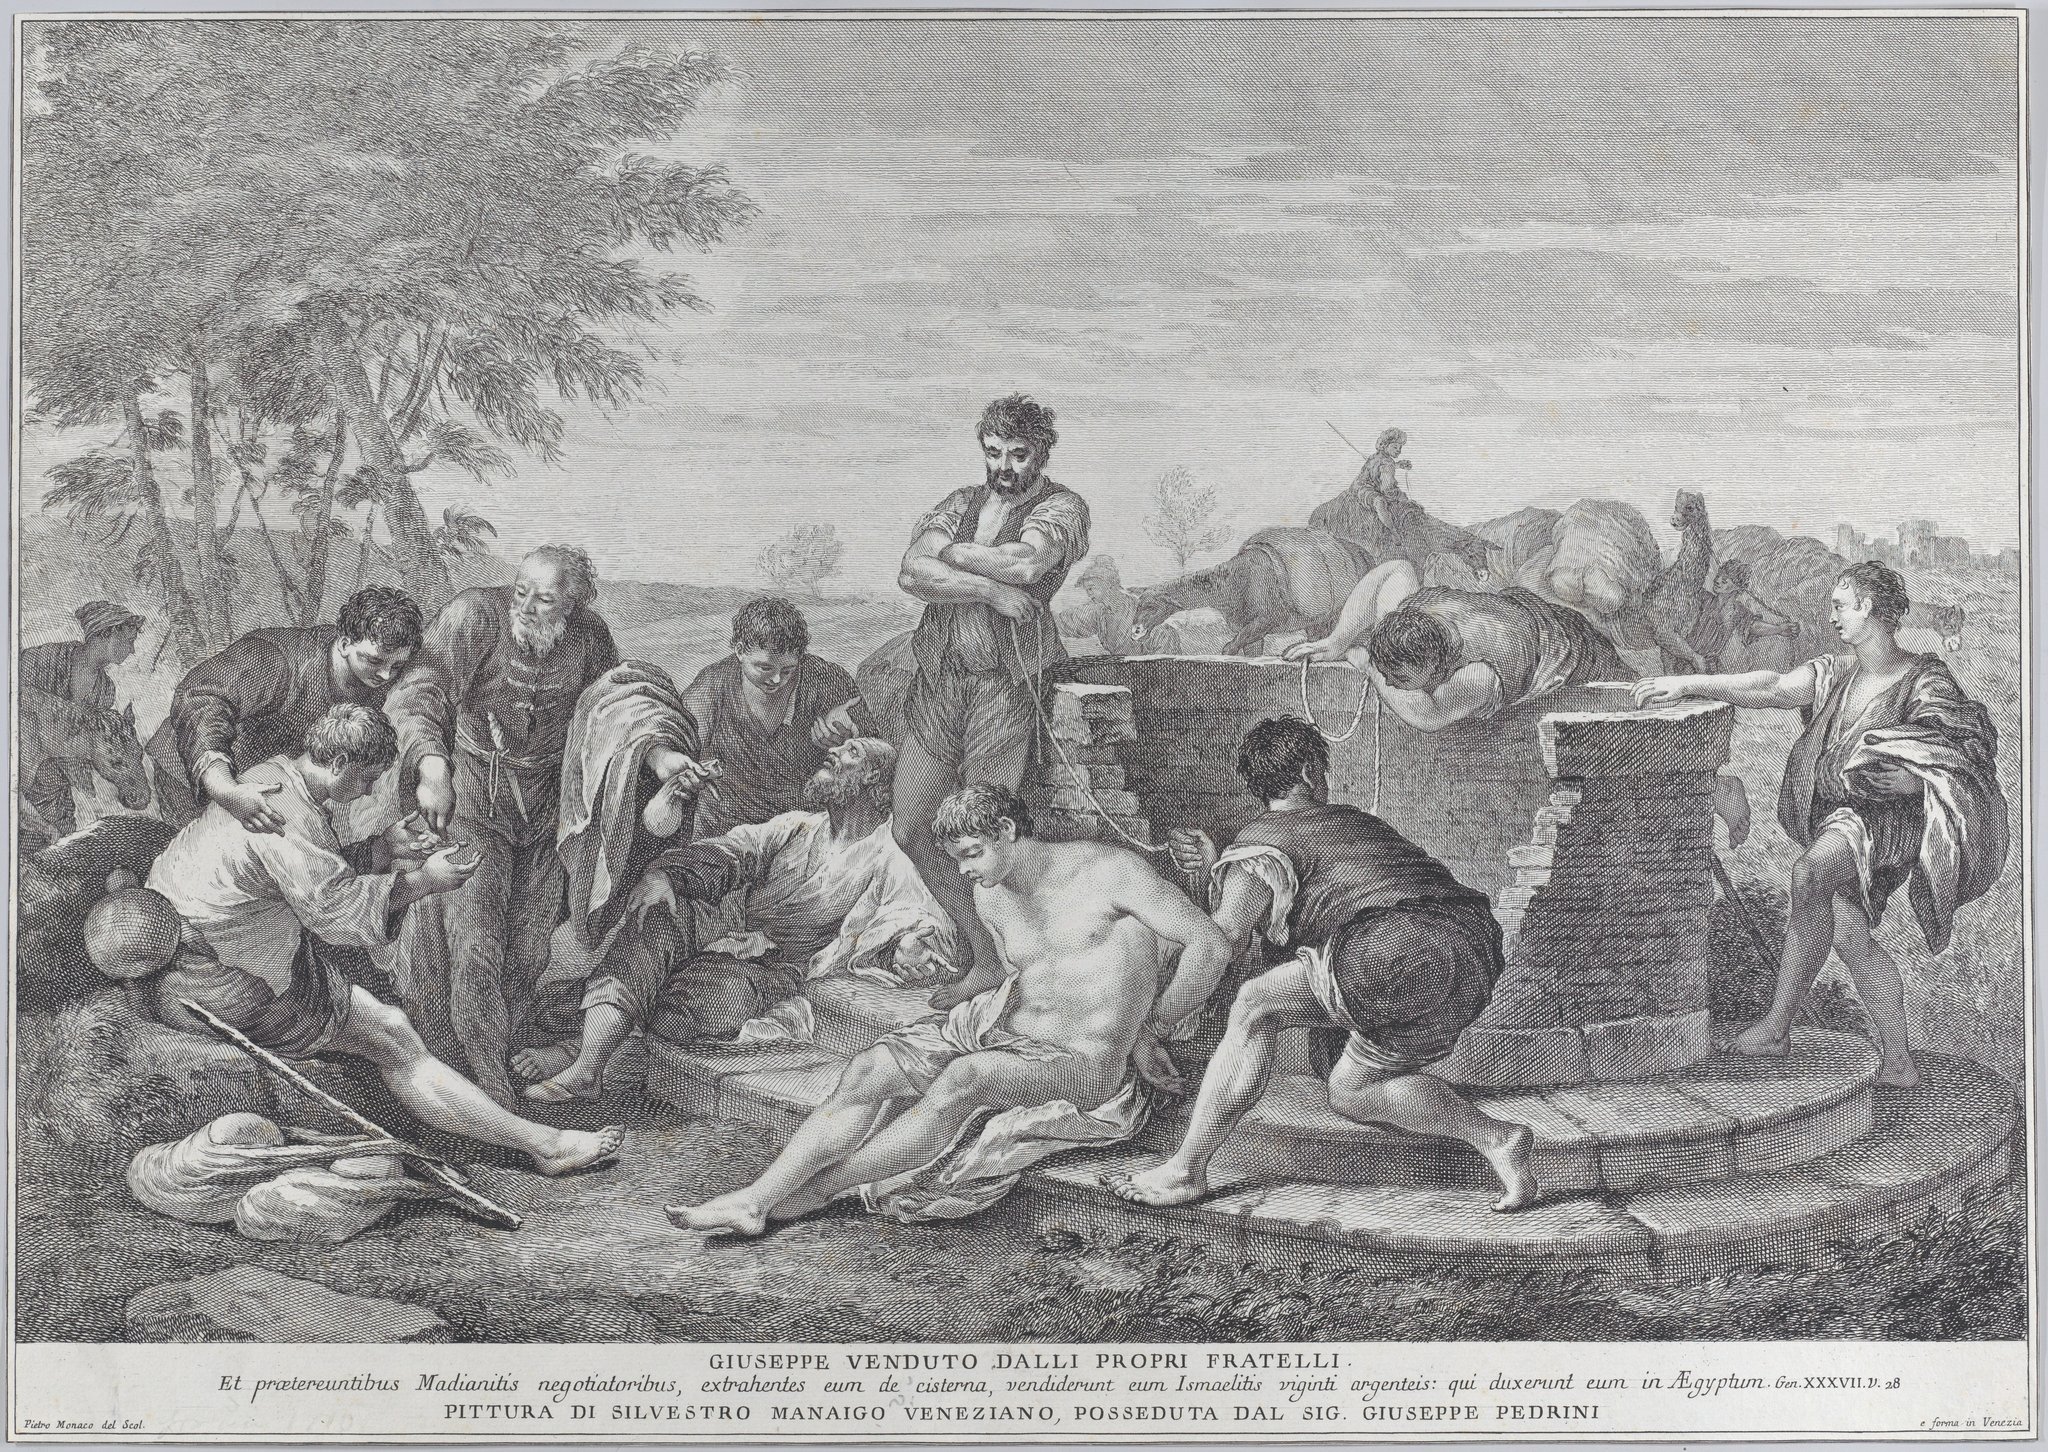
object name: print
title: Joseph being sold into slavery by his brothers, who sit around a well dividing up the coins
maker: pietro monaco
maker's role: artist and publisher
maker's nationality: italian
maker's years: 1707-1772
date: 1730-1739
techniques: etching